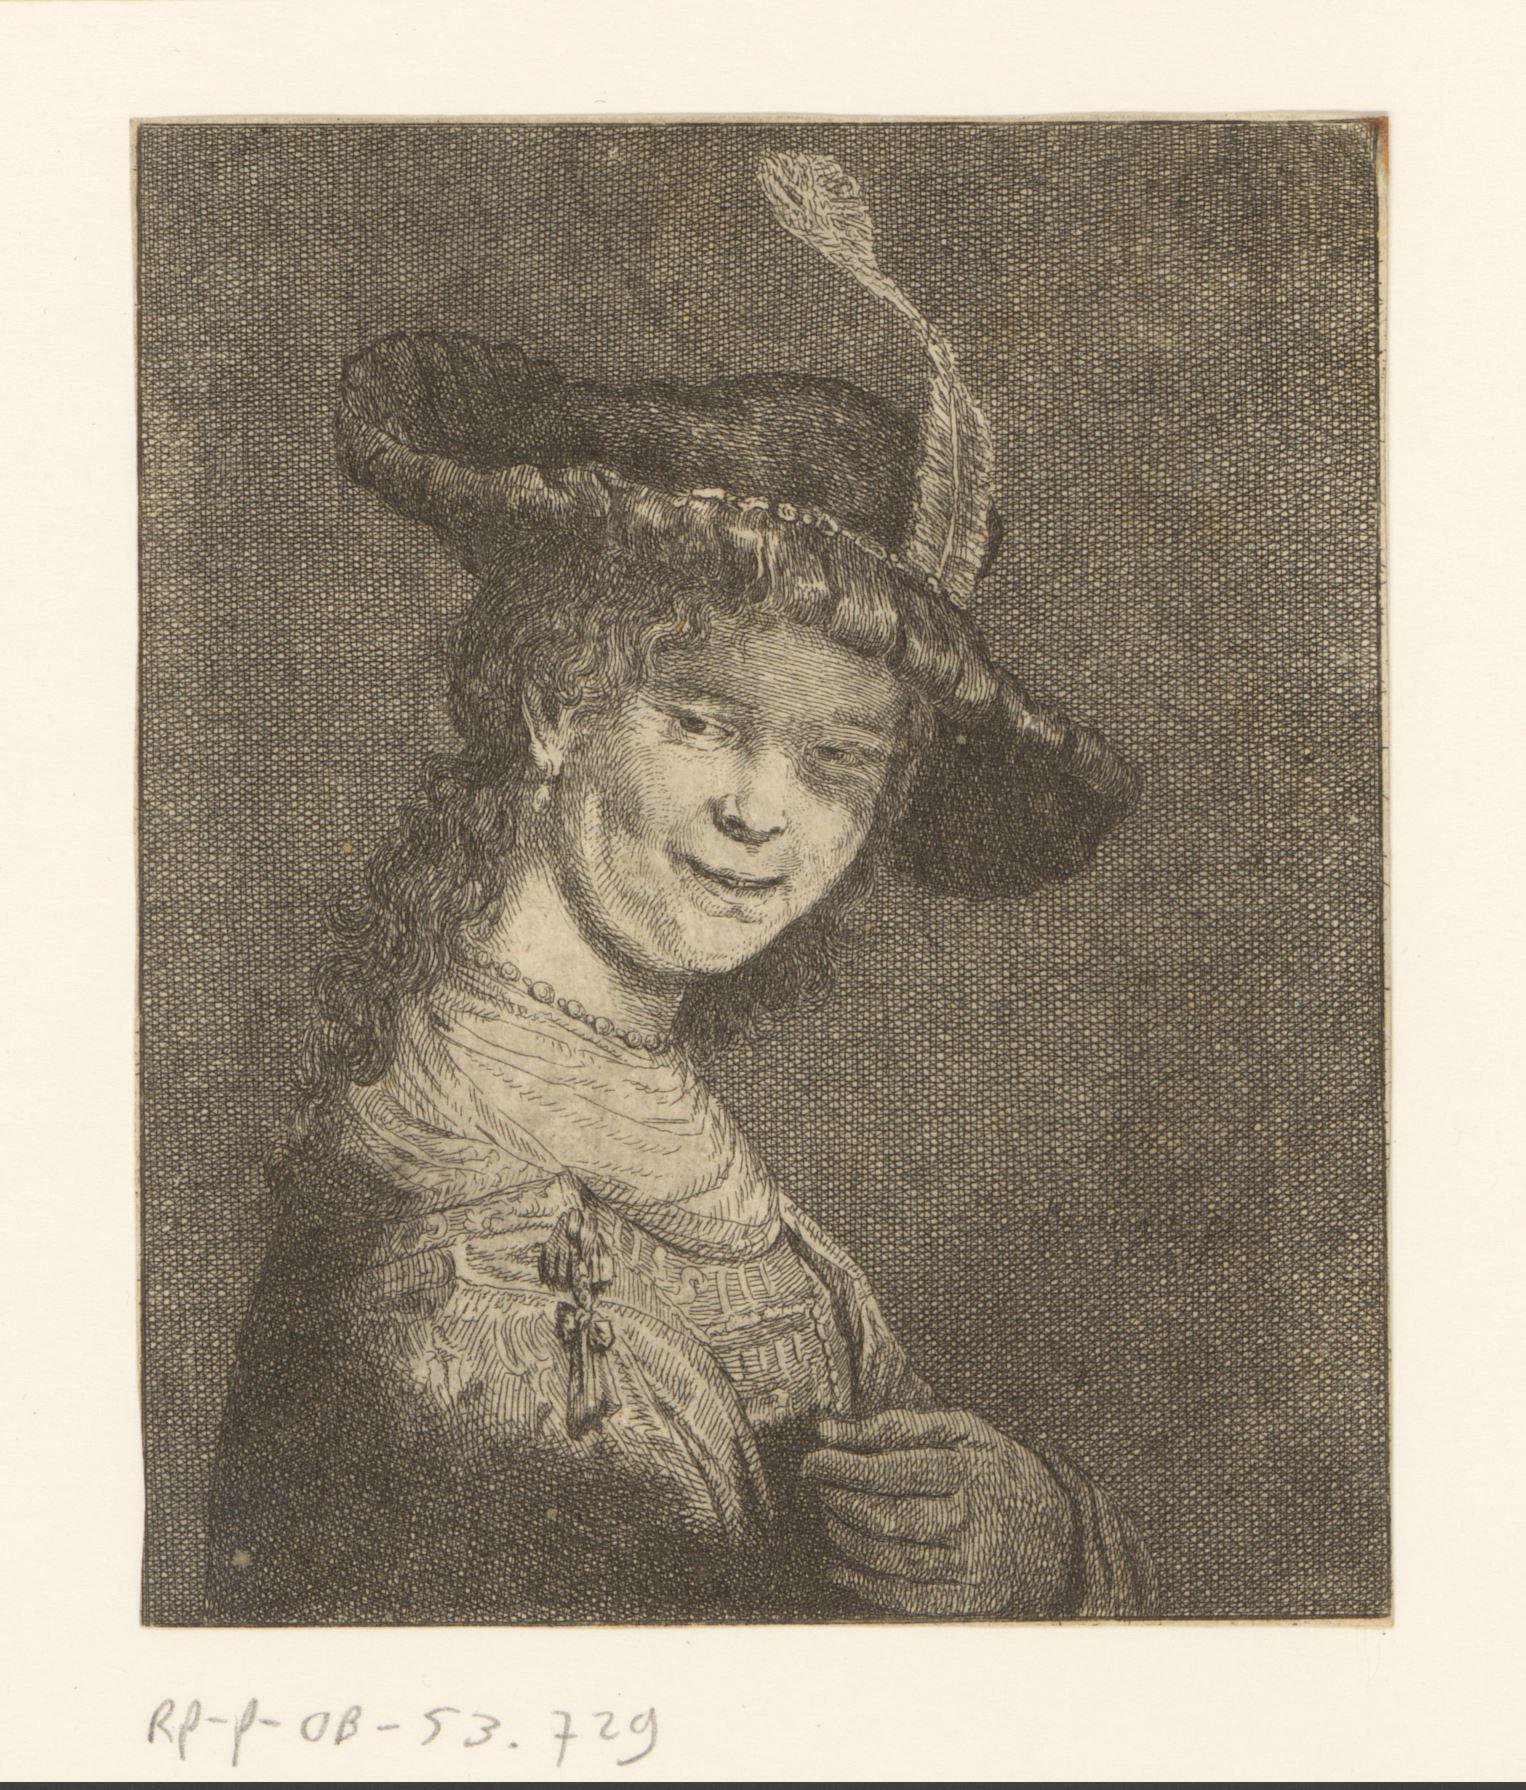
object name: print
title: Portret van een onbekende glimlachende vrouw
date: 1746-1816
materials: paper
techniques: etching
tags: adolescent, young woman, maiden, smiling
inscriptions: collector's mark: Lugt 240